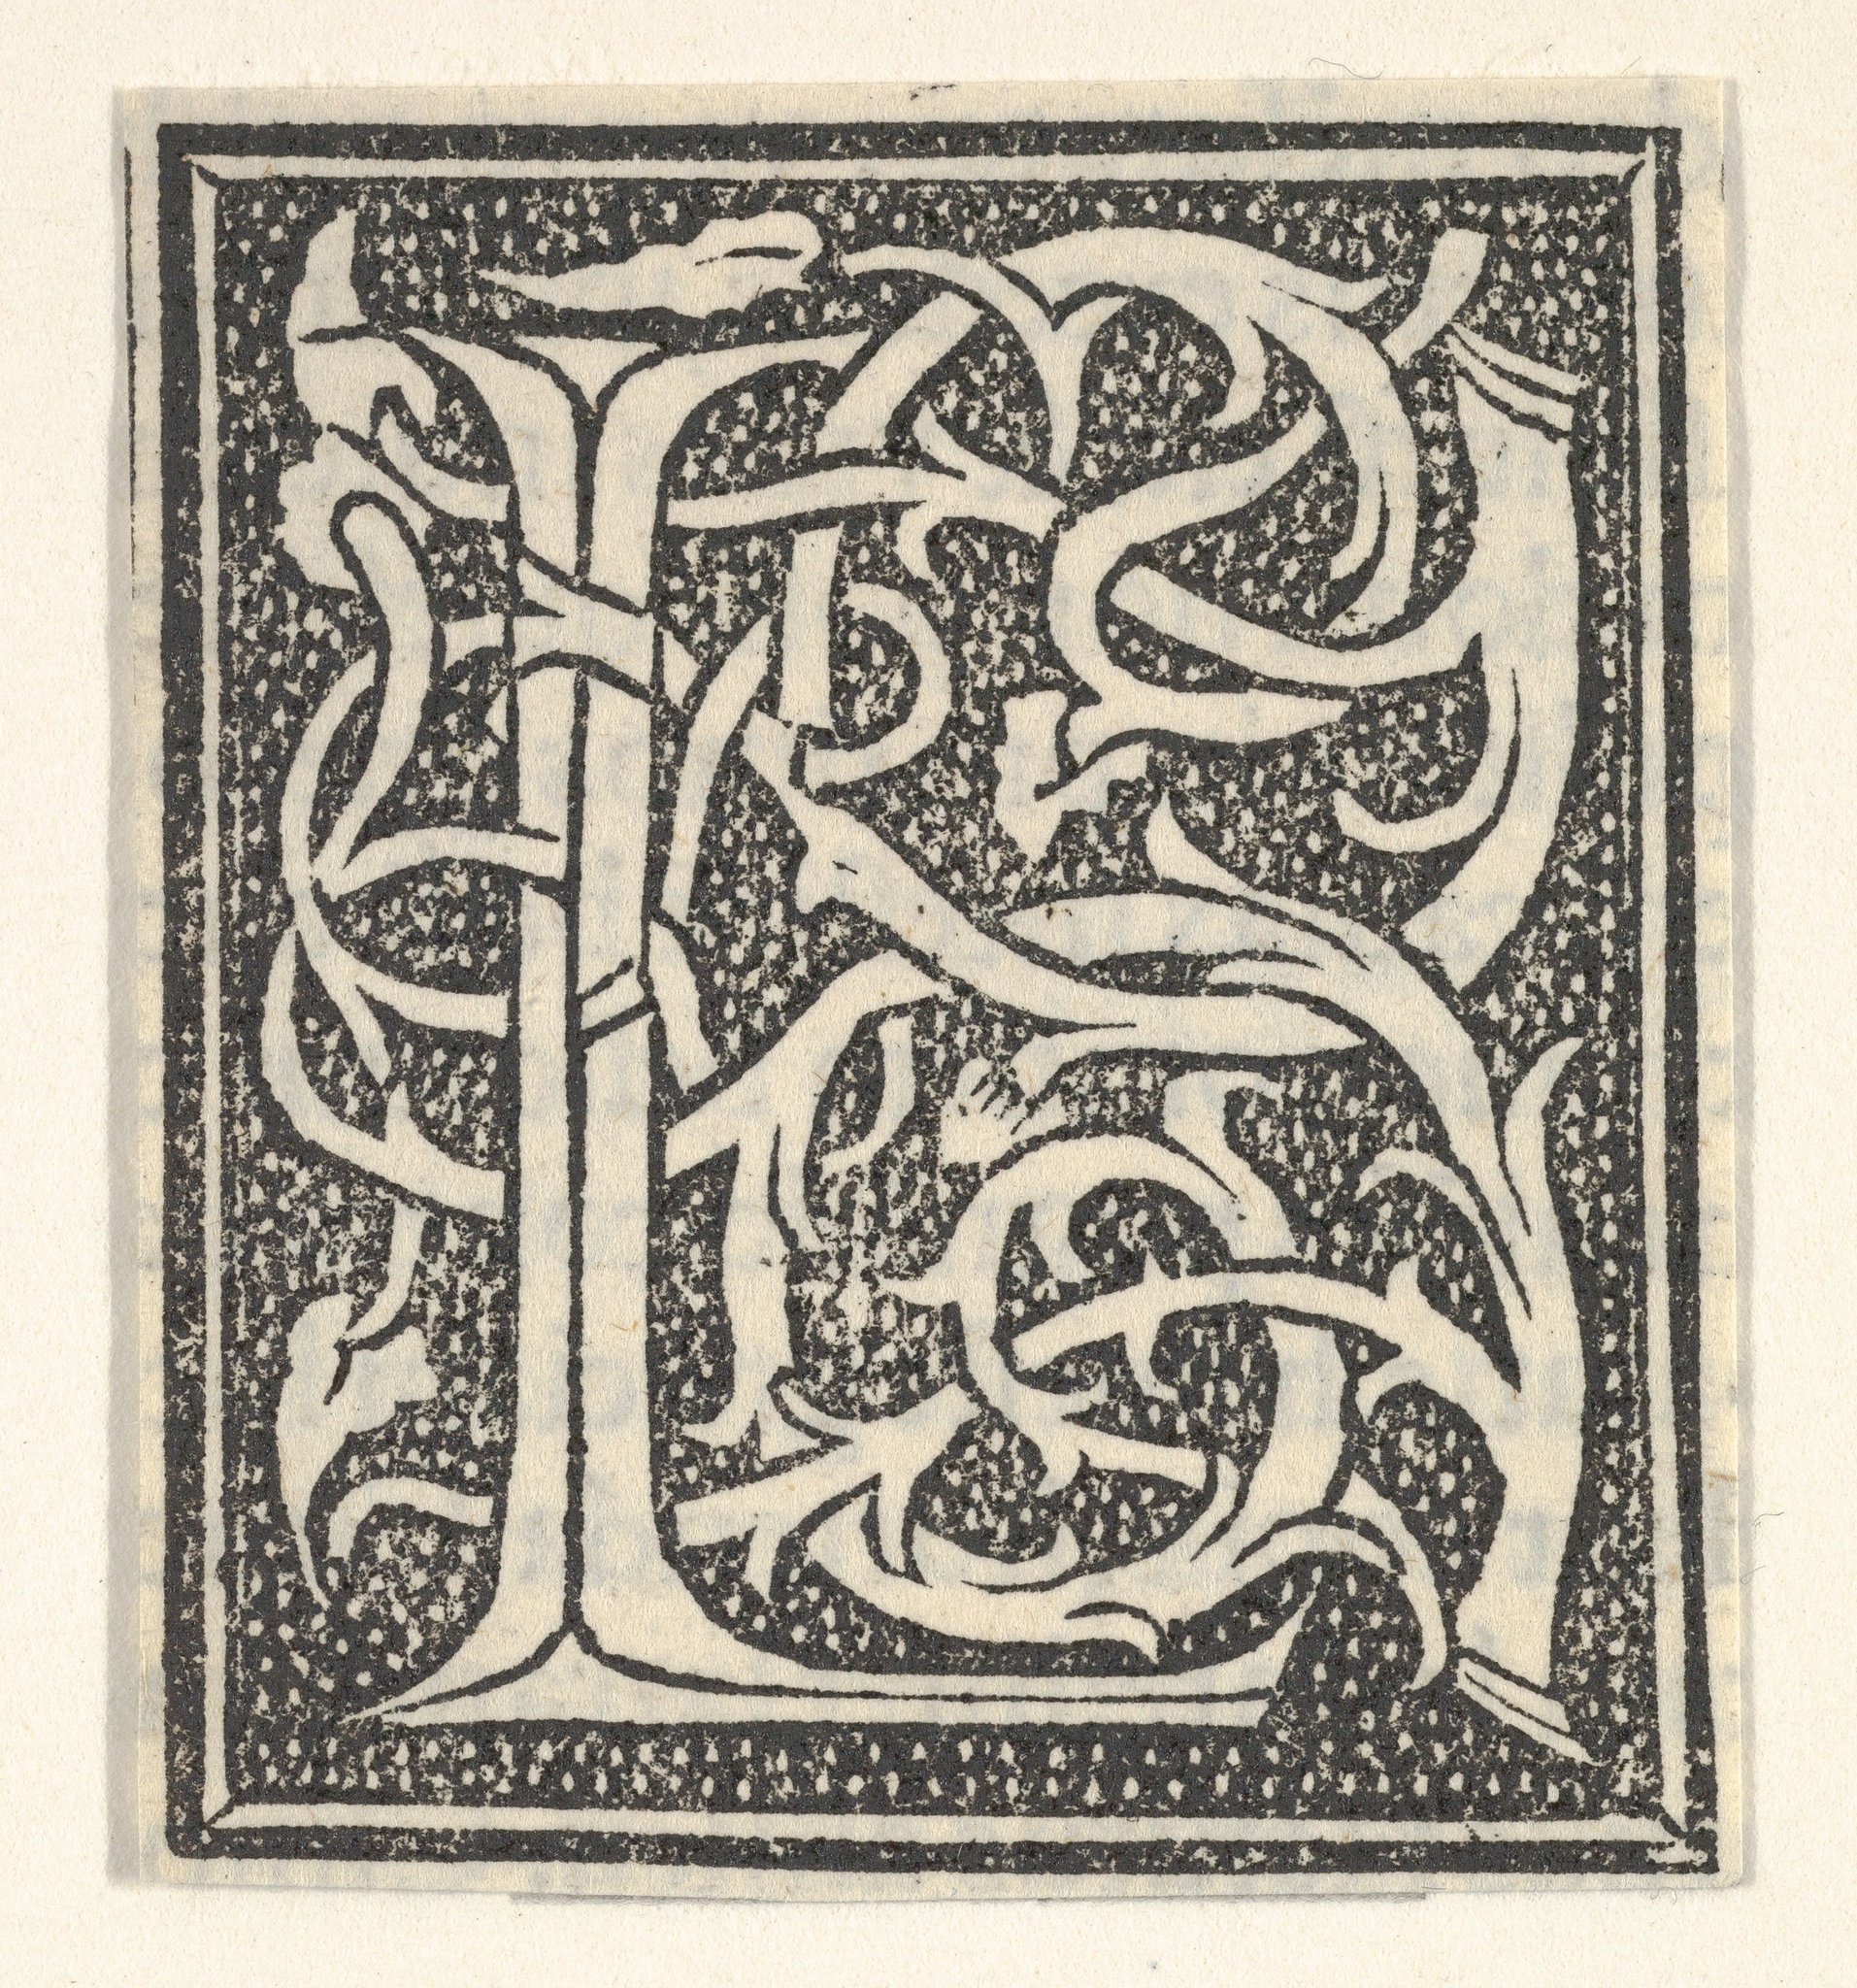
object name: print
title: Initial letter L on patterned background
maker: anonymous, italian, 16th century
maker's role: artist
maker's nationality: italian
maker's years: 1500-1600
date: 1520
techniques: woodcut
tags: leaves